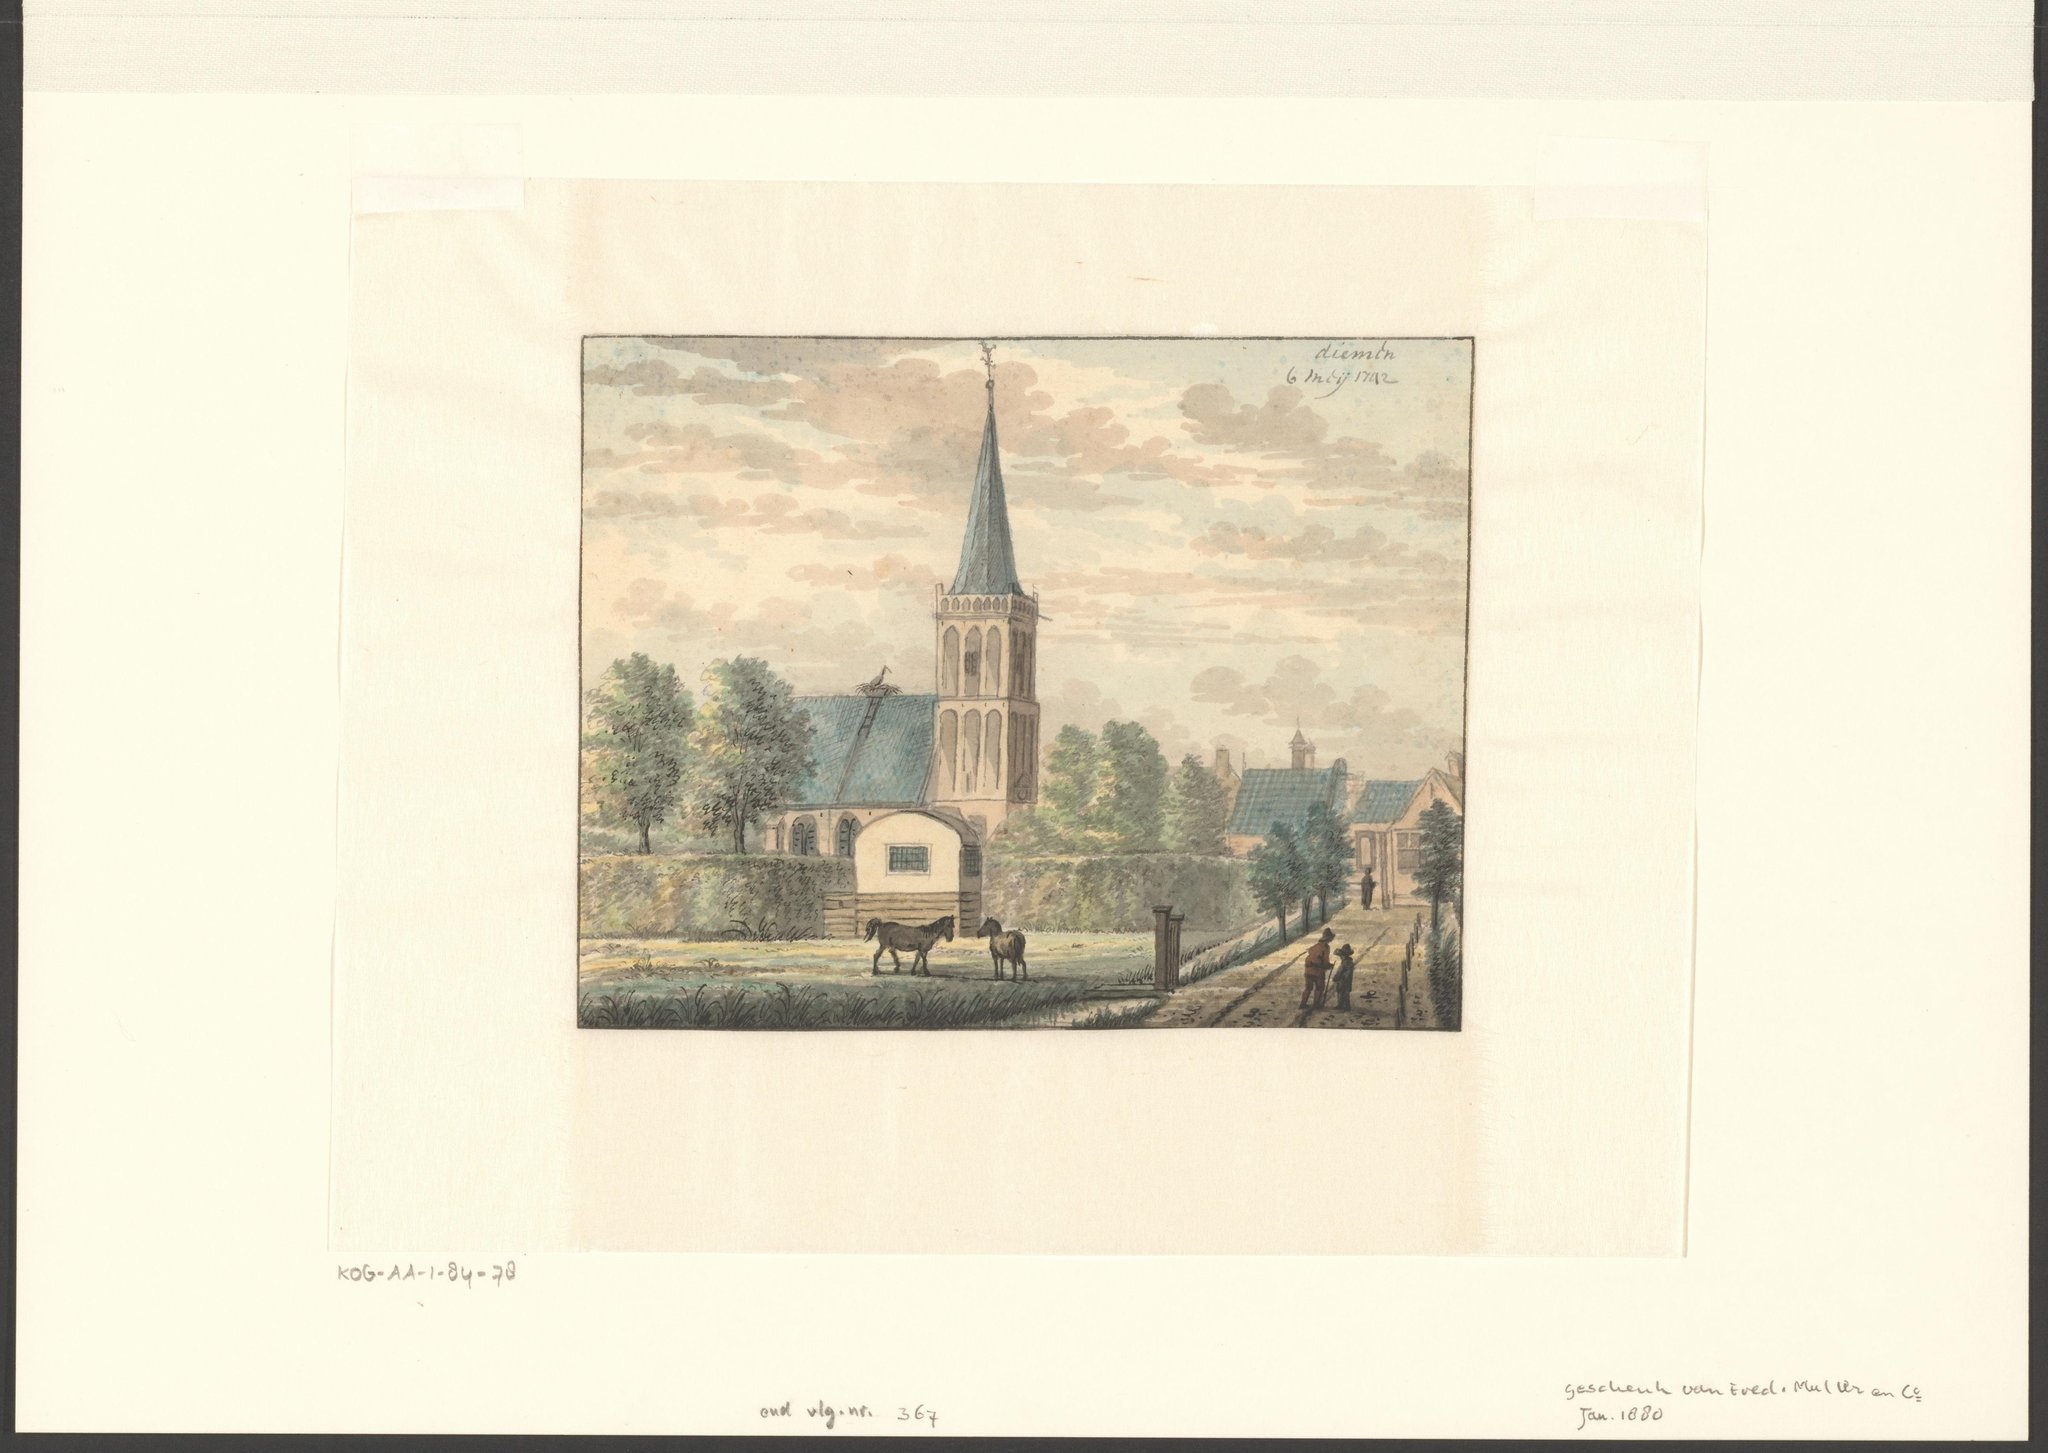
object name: drawing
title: Gezicht op de kerk in Diemen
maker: Anonymous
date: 1742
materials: ink, paper, pencil, watercolor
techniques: brush, pen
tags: village, church (exterior), road, path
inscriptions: inscription: ‘geschenk van Fred. Muller en Co / Jan. 1880’, date: ‘diemen / 6 Meij 1742’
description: Onderwerpsrubriek binnen de Atlas Amsterdam: Diemen (Oud), Diemerbrug.